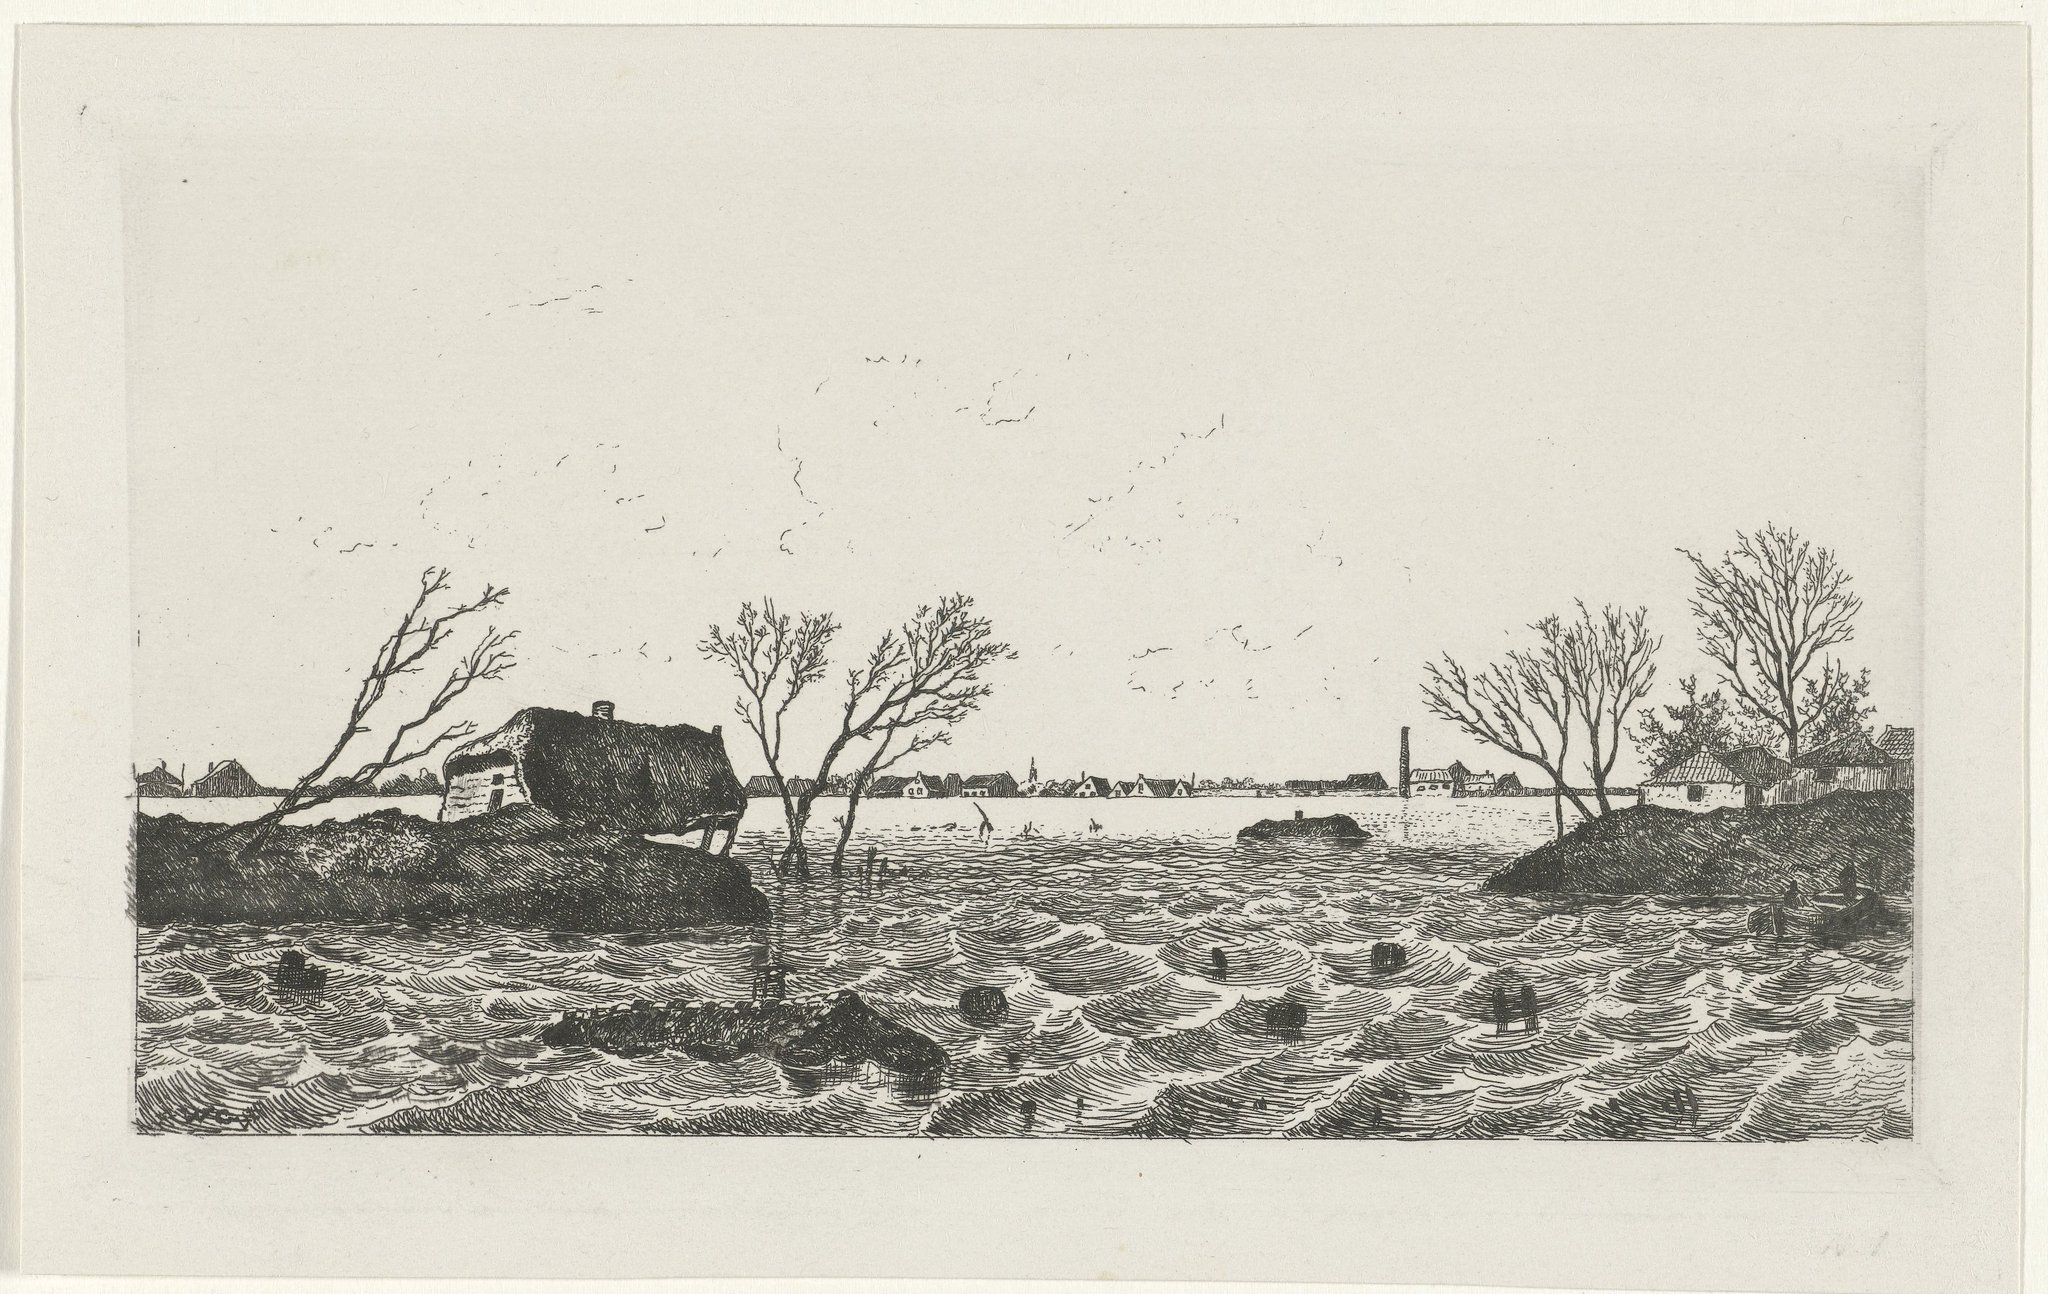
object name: print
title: Dijkdoorbraak bij Dreumel, 1855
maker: willem gruyter jr.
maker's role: draughtsman, print maker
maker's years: 1817-1880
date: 1832-1880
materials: paper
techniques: etching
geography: amsterdam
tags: dike-break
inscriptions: collector's mark: Lugt 2165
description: Landschap met dijkdoorbraak bij Dreumel tijdens de watersnoodramp in 1855.